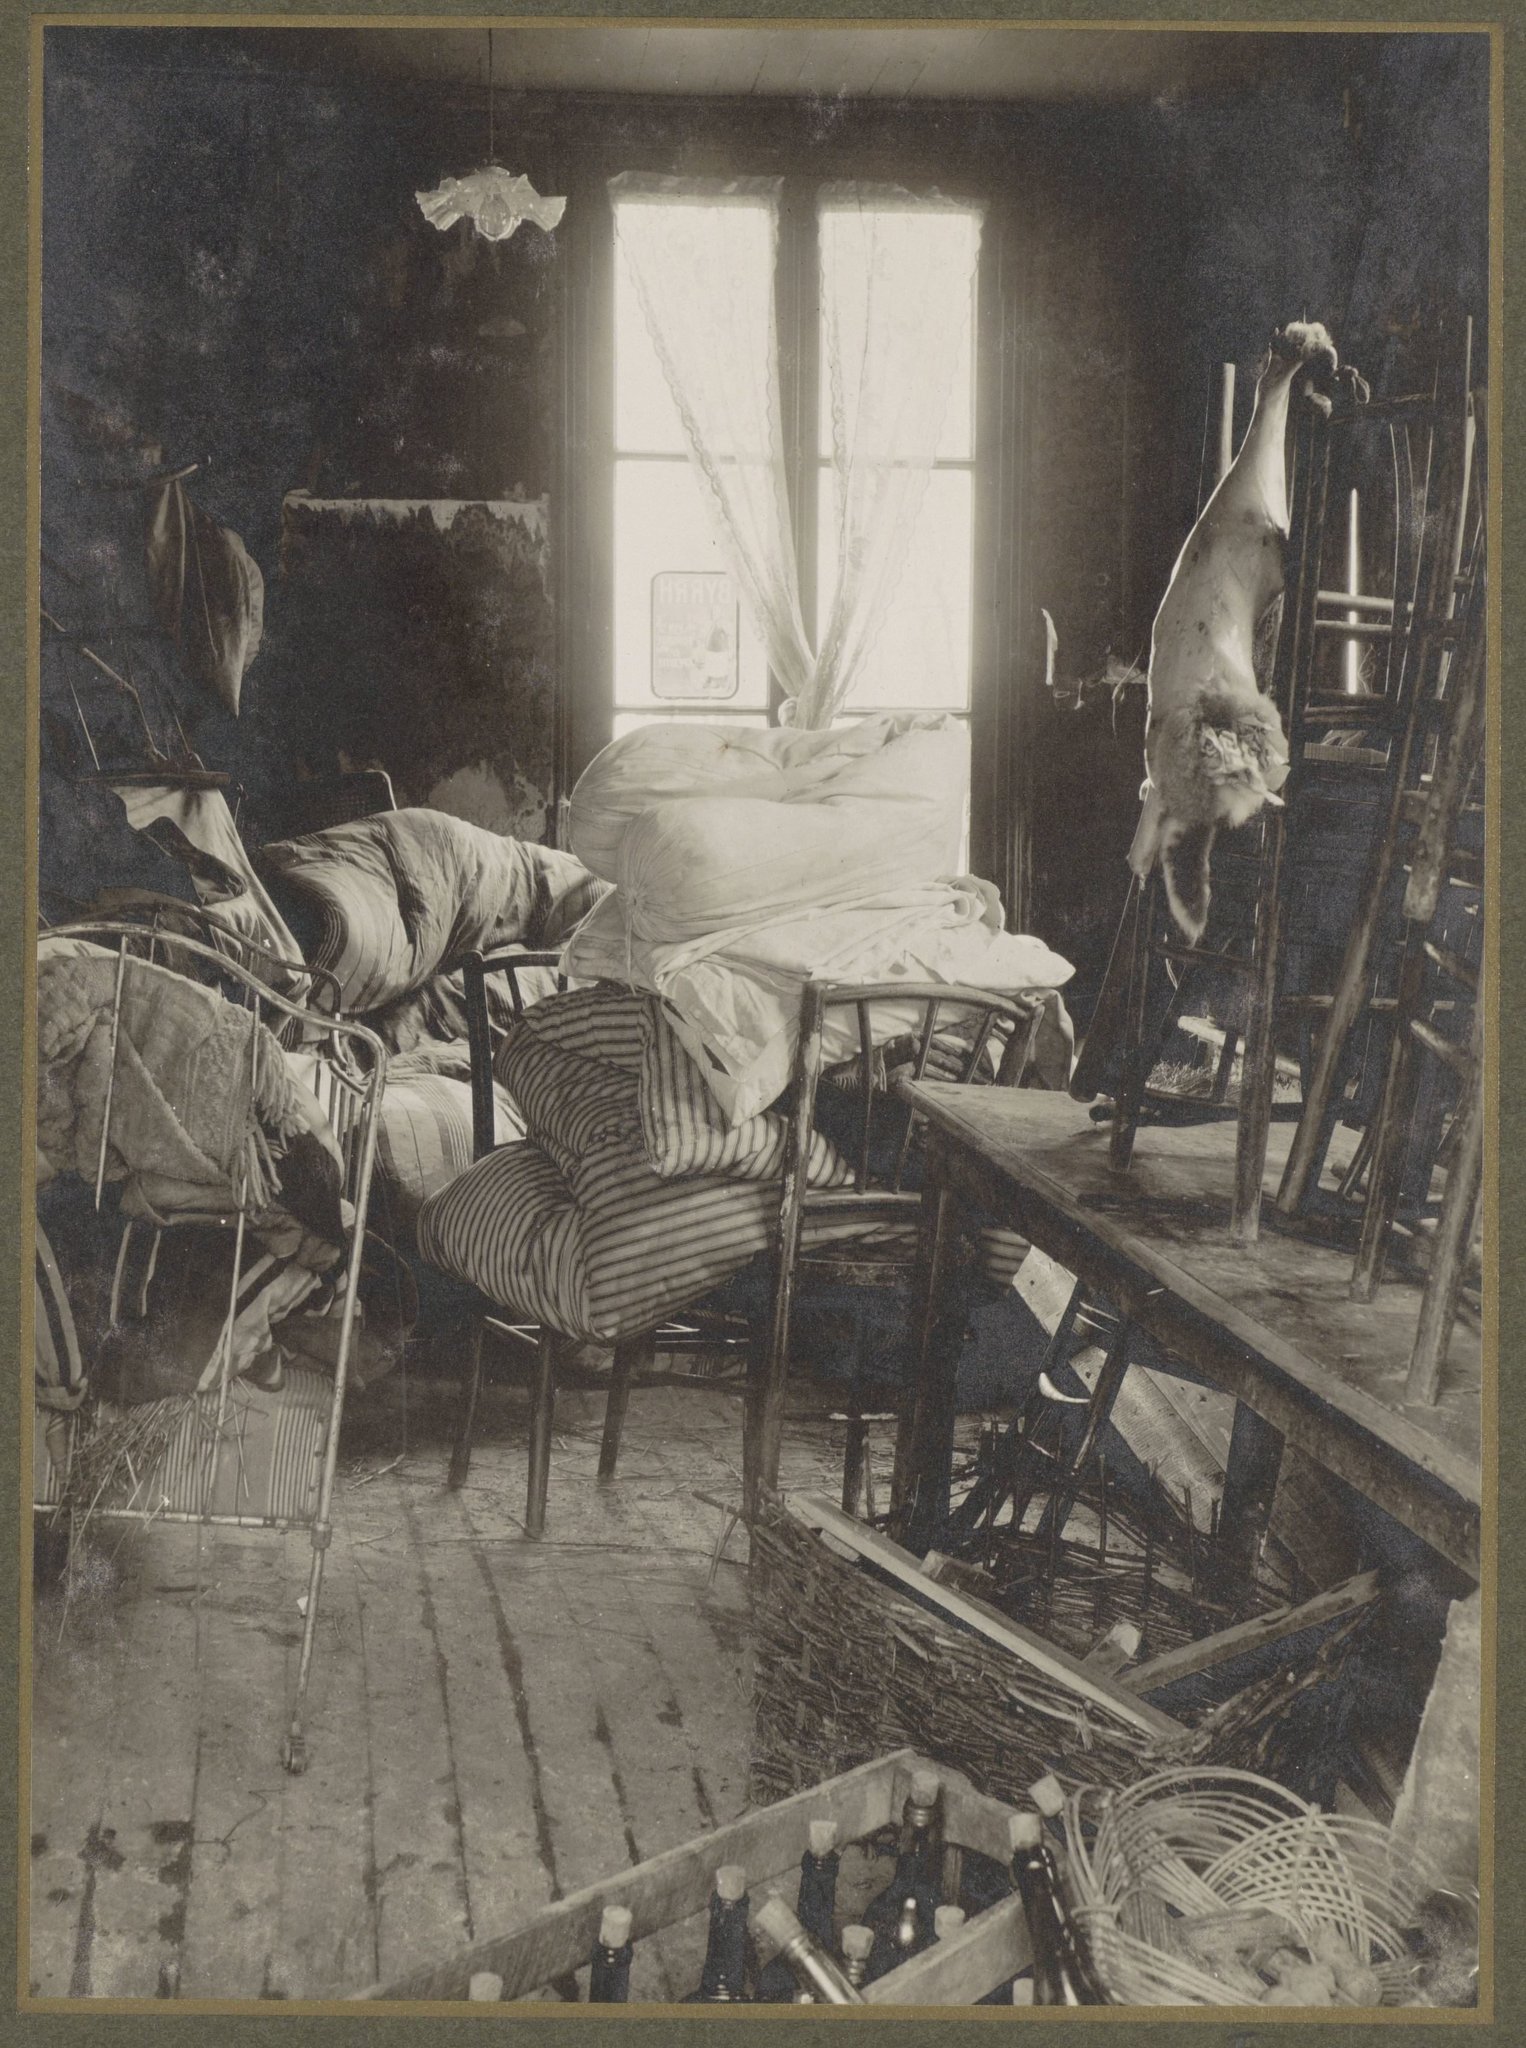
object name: photograph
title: Kamerinterieur met gered meubilair en beddengoed tijdens de overstroming van Parijs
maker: g. dangereux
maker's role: fotograaf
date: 1901-1910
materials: photographic support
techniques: matte daylight collodion silver print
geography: paris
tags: flood (+ landscape with figures, staffage), interior of the house, paris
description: Onderdeel van fotoalbum overstroming Parijs en voorsteden 1910.